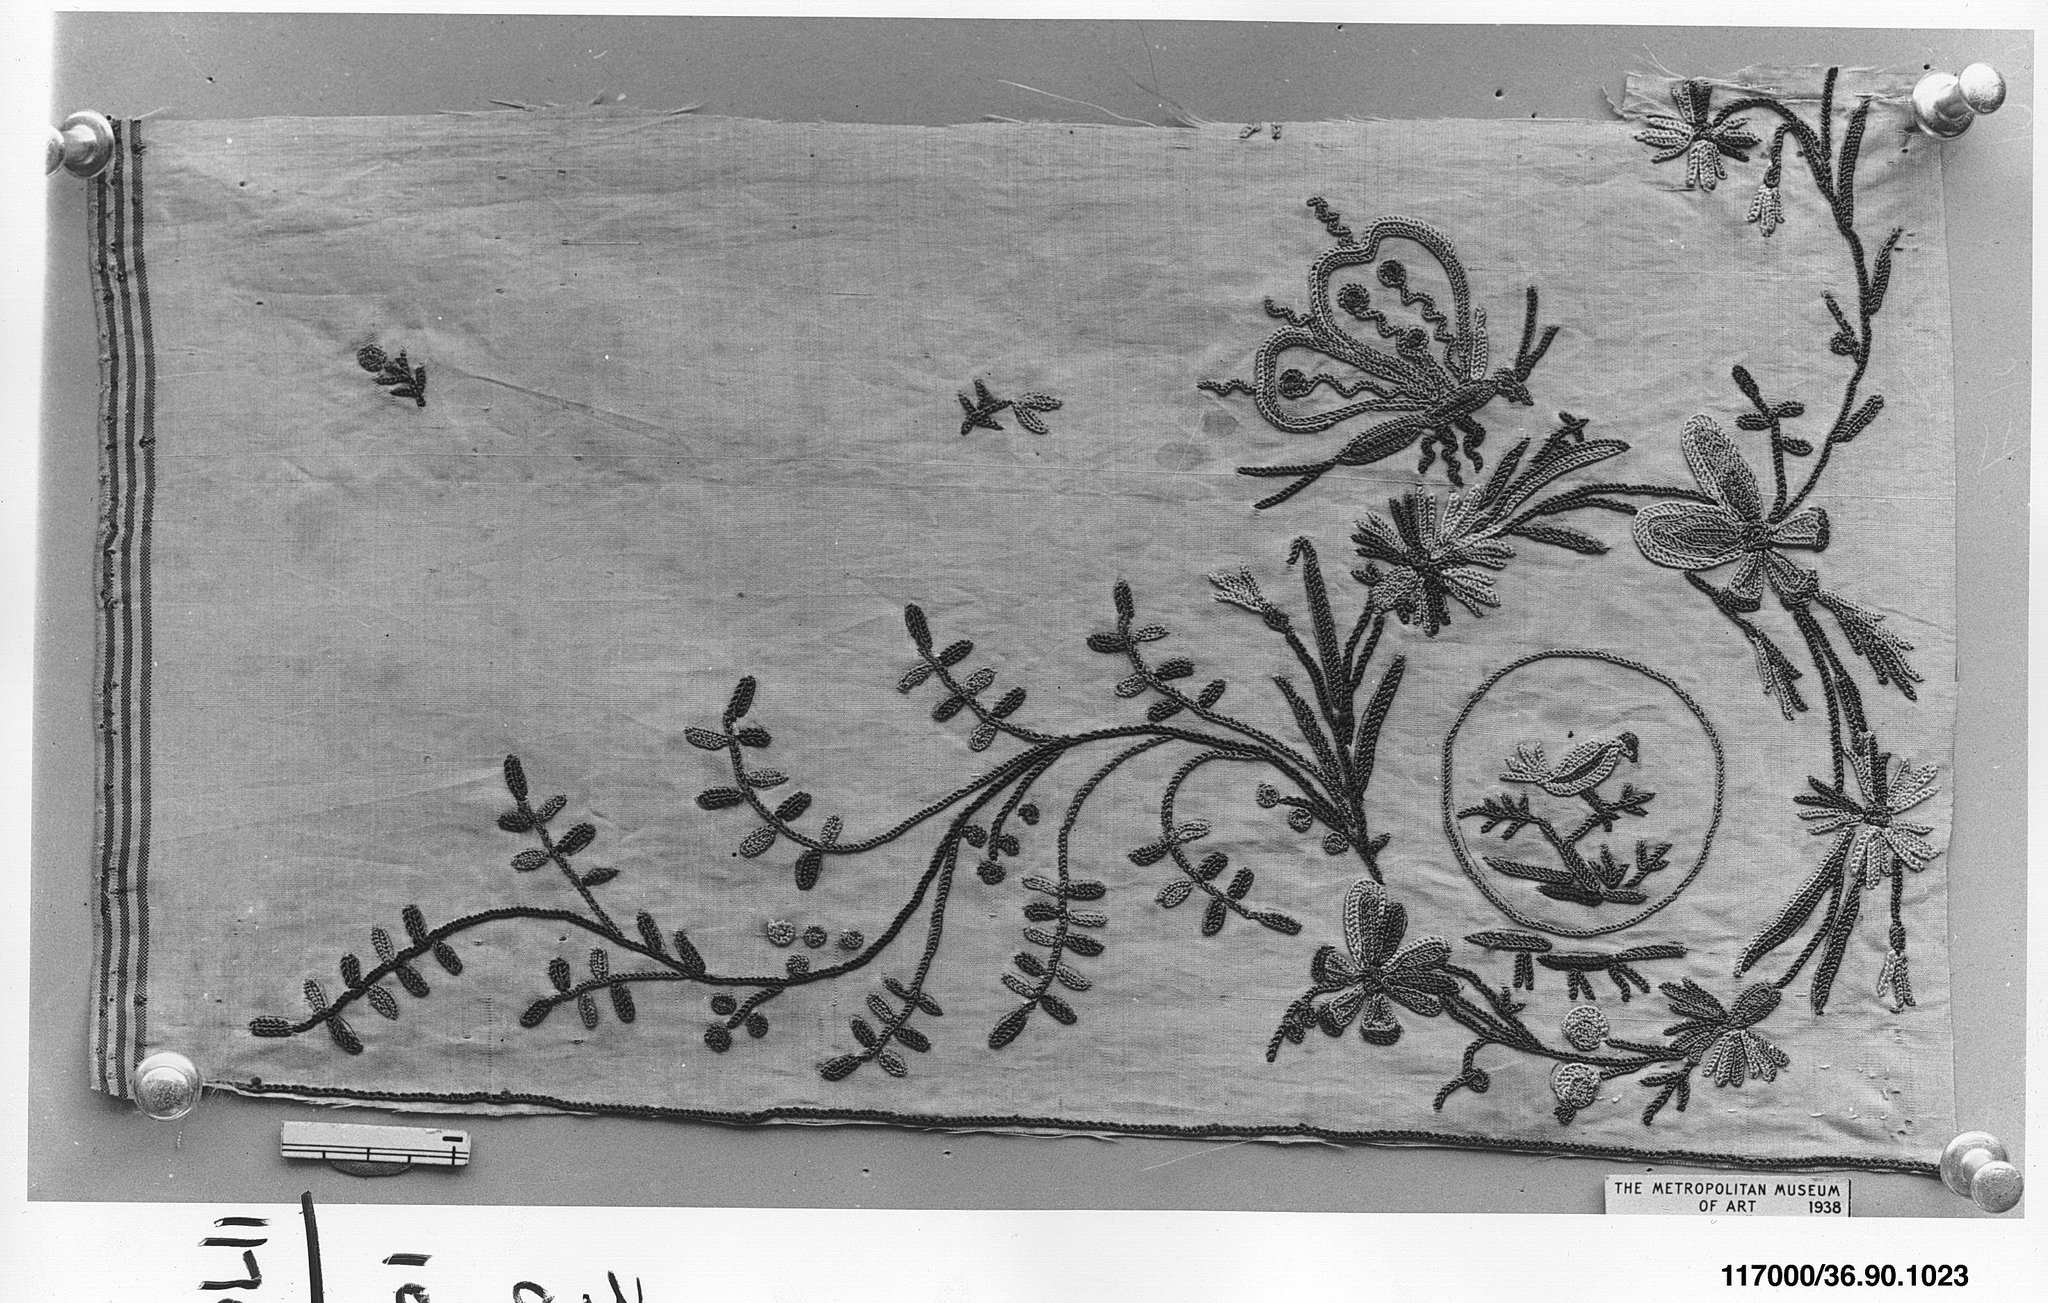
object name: piece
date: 1701-1800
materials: silk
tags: birds,butterflies,flowers,leaves